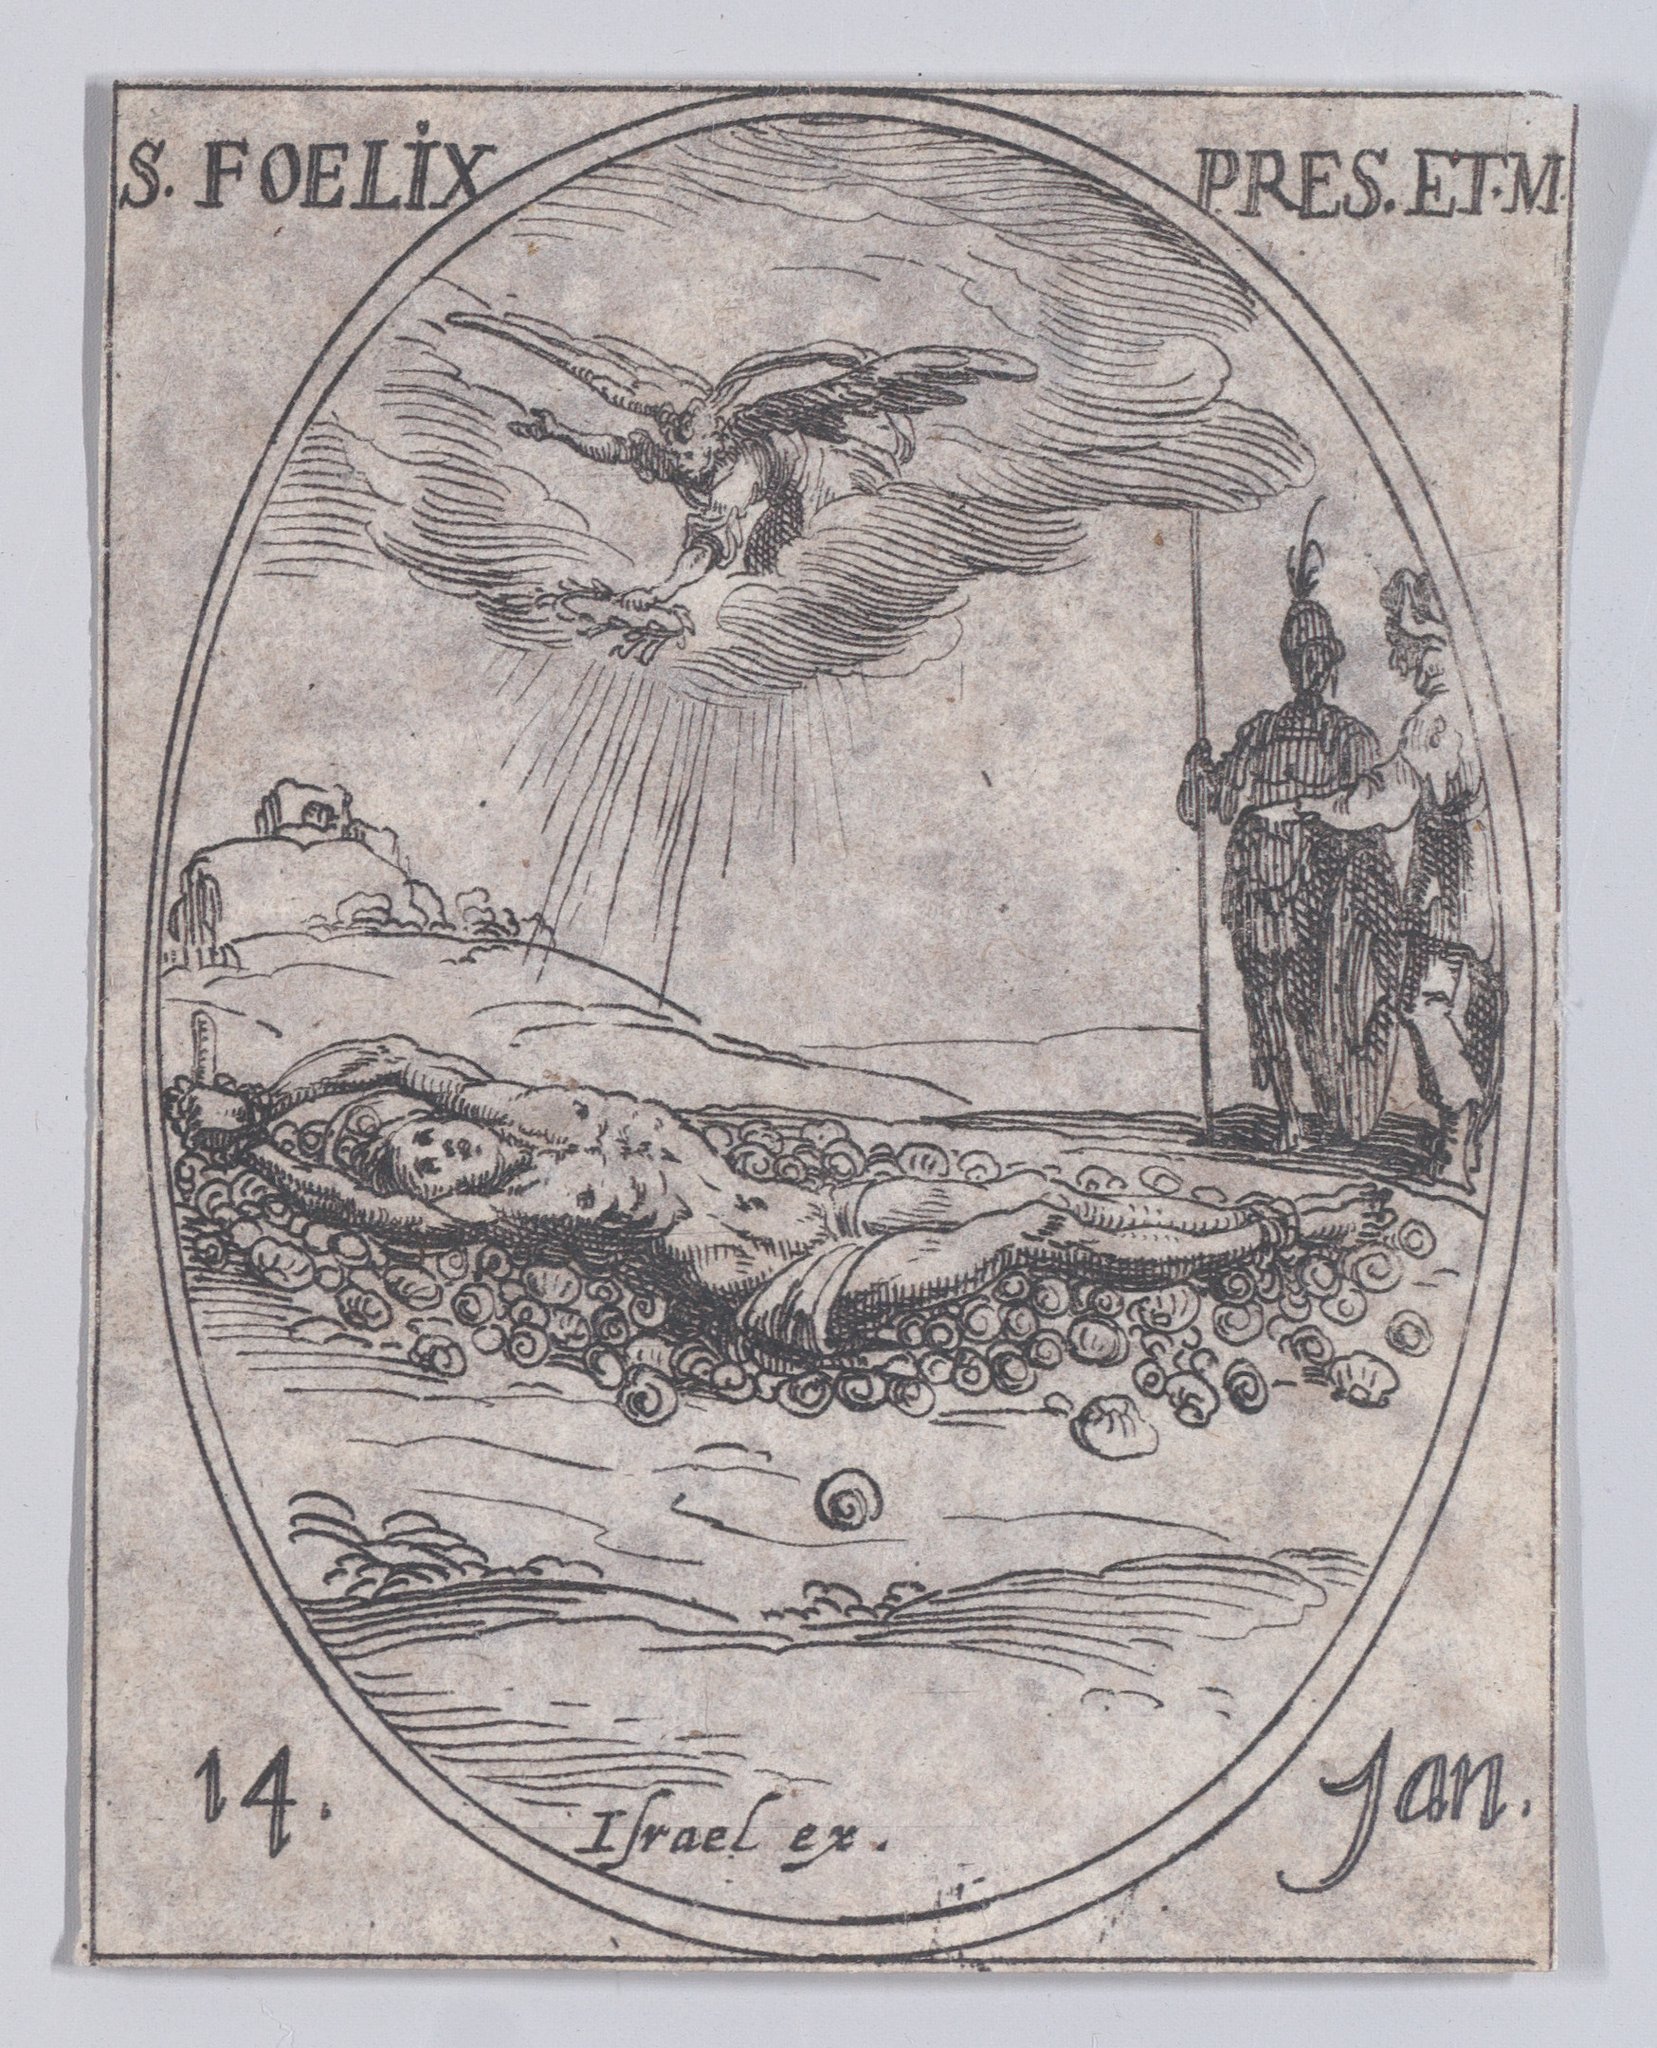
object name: print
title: S. Félix, prètre et martyr (St. Felix, Priest and Martyr), January 14th, from "Les Images De Tous Les Saincts et Saintes de L'Année" (Images of All of the Saints and Feast Days of the Year)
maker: jacques callot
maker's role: artist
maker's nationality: french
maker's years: 1592-1635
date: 1636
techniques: etching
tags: men,angels,saints